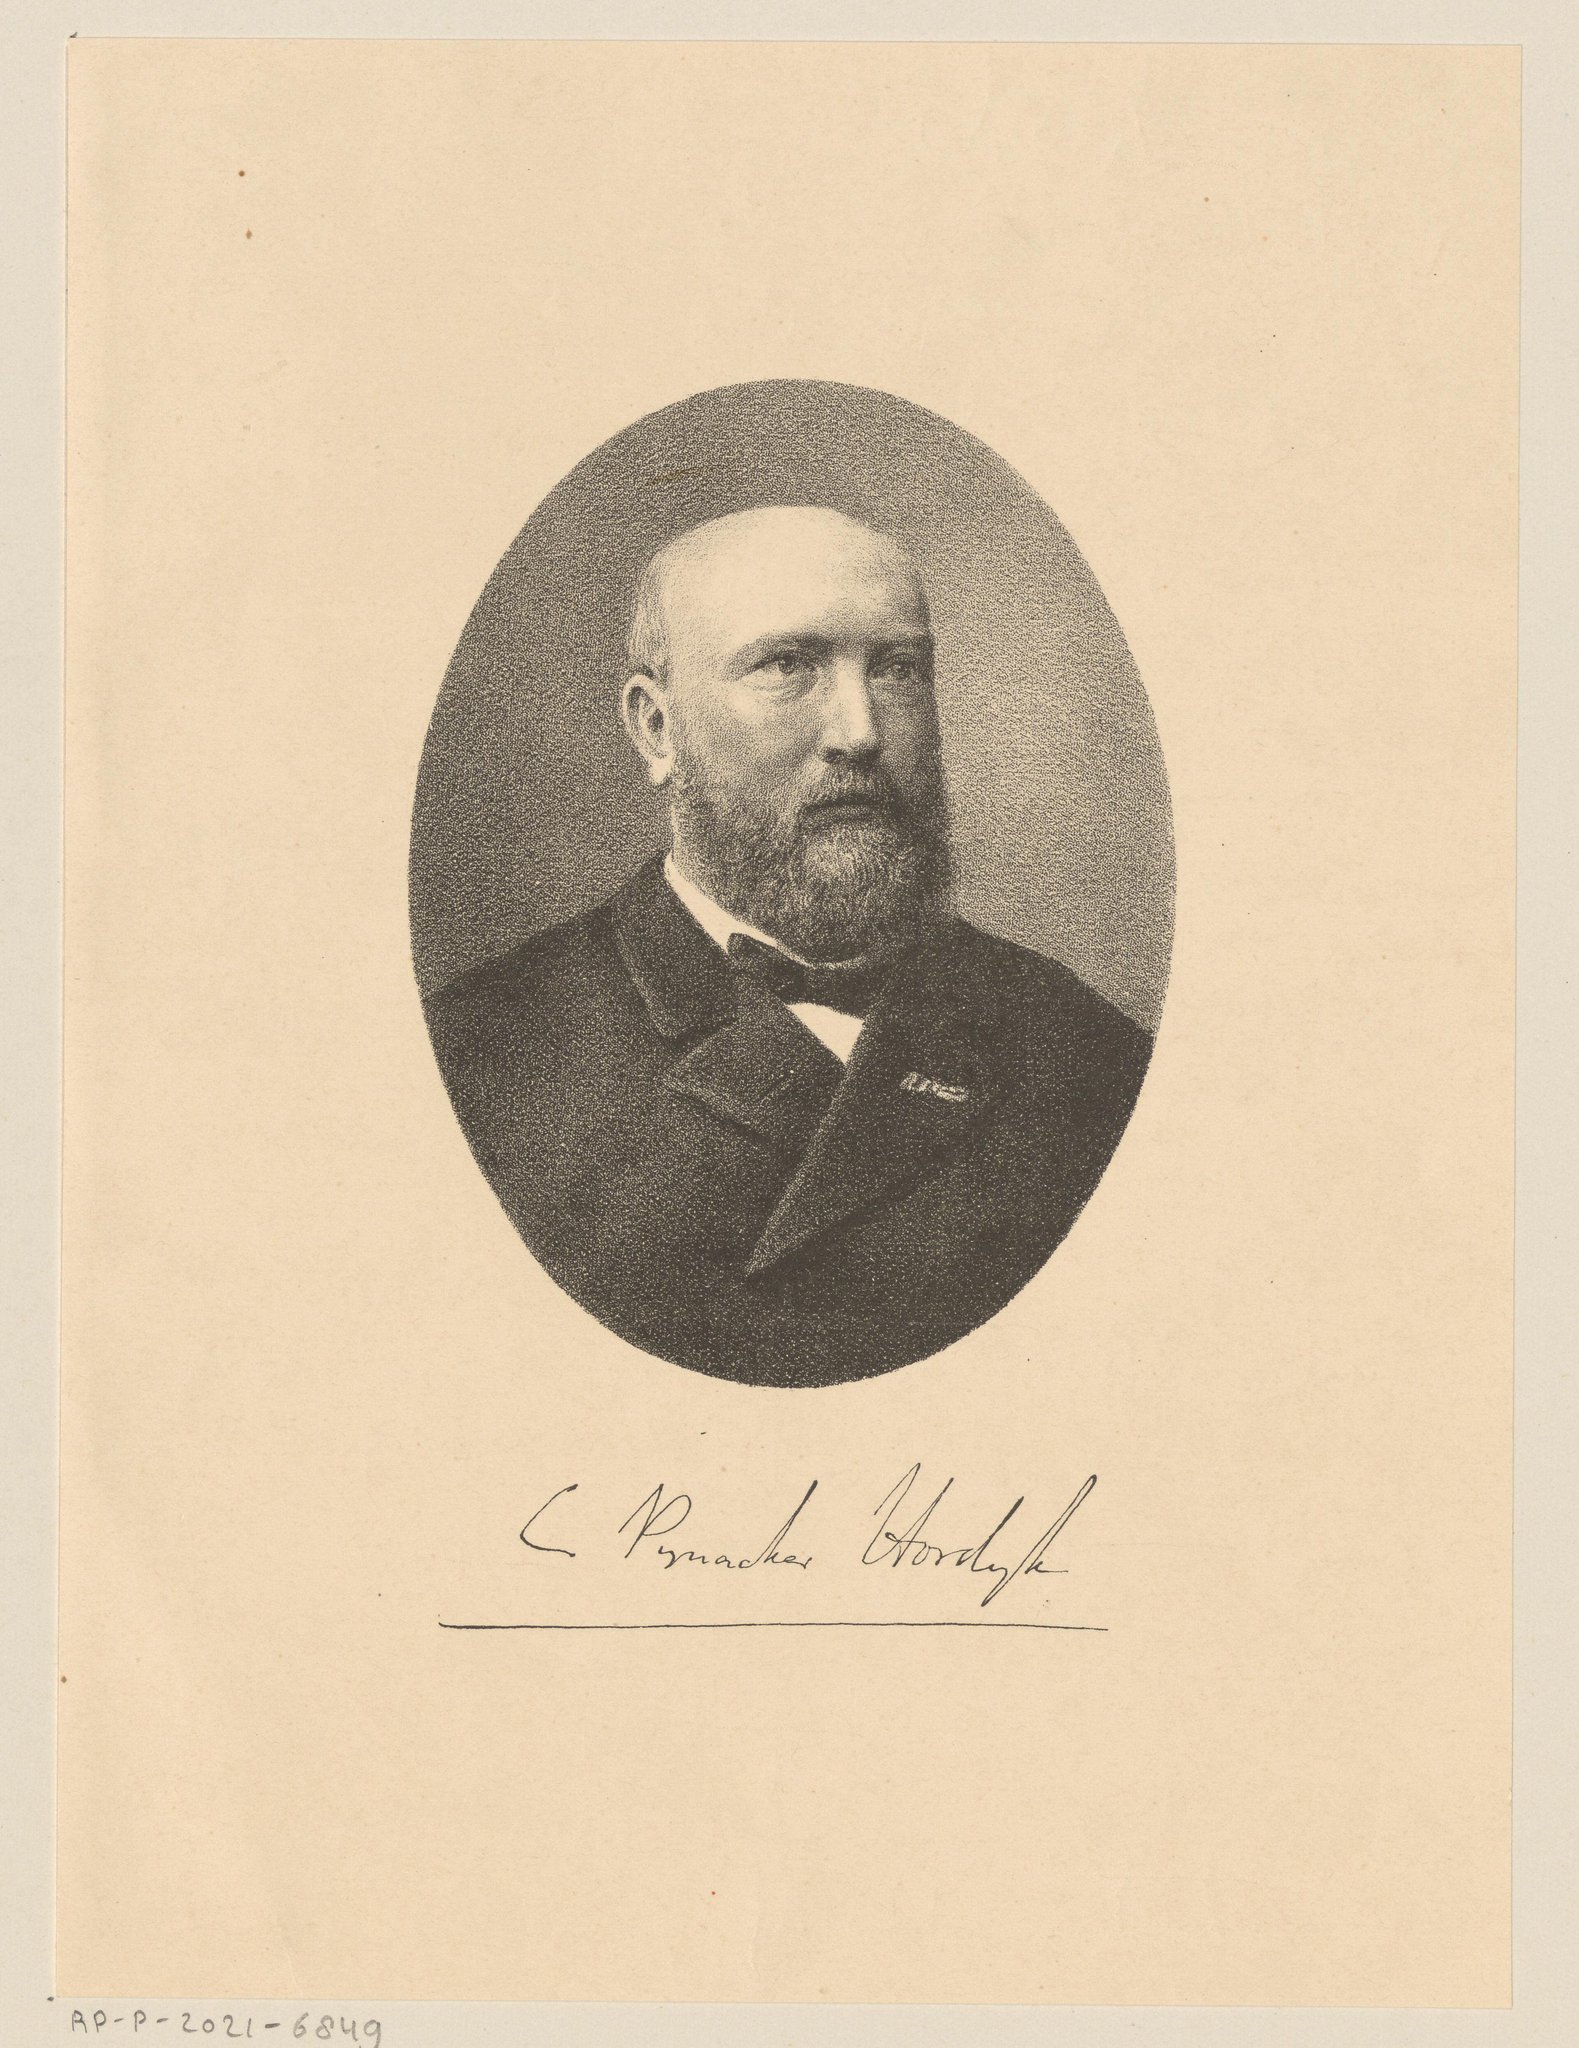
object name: print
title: Portret van Cornelis Pijnacker Hordijk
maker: Anonymous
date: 1880-1920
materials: paper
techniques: lithograph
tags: historical persons, politician, e.g. party leader